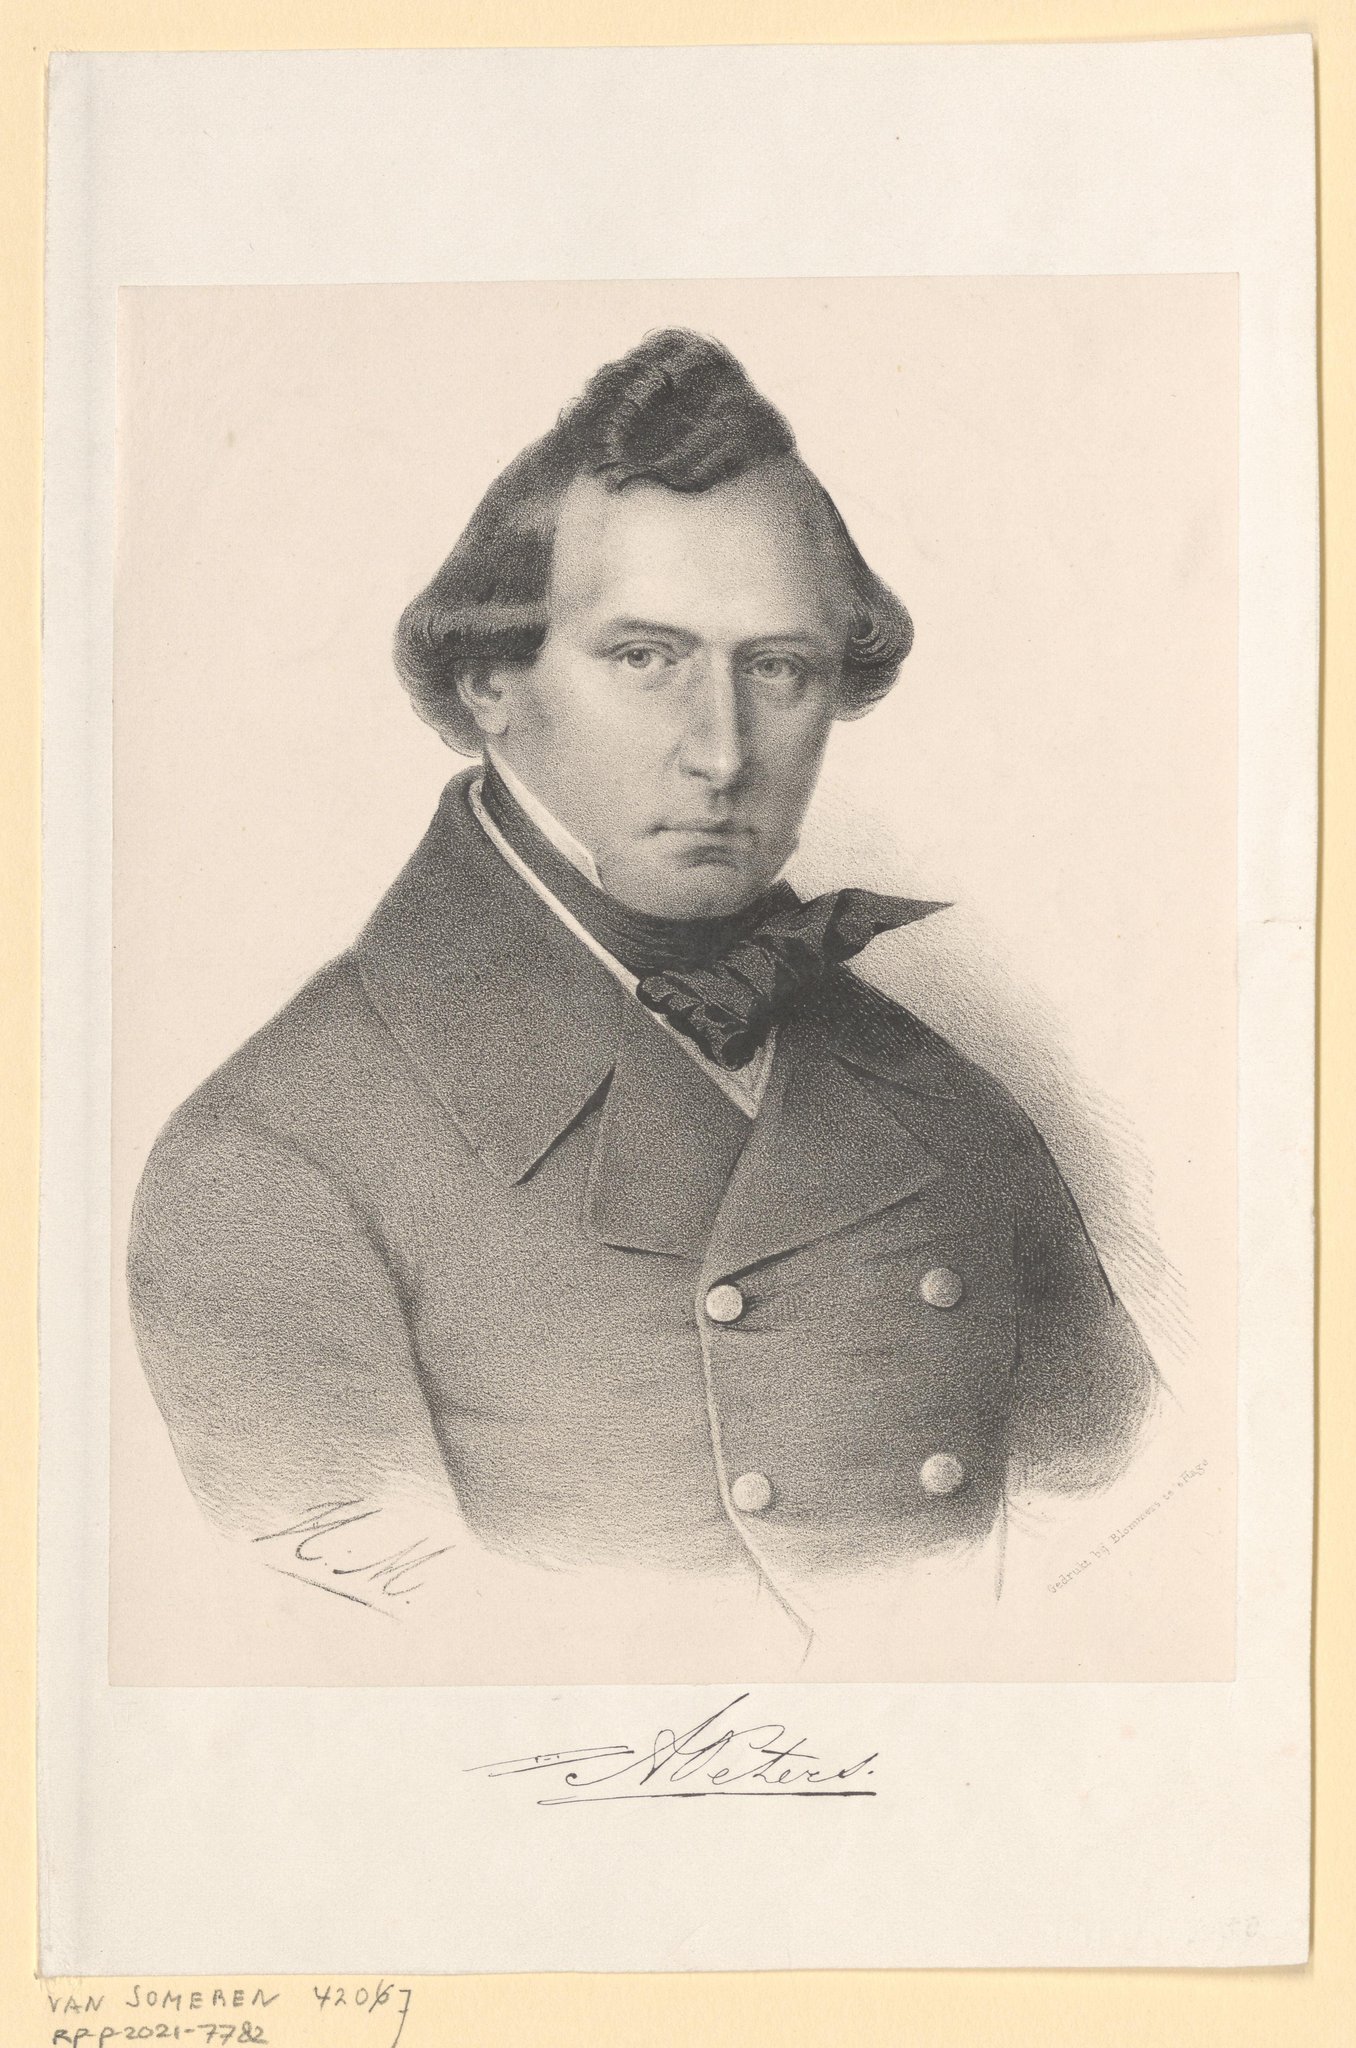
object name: print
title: Portret van Anton Peters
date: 1842-1887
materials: paper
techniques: lithograph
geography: the hague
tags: anton peters, adult man, historical persons, portrait of actor, actress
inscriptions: initials: ‘H.M.’